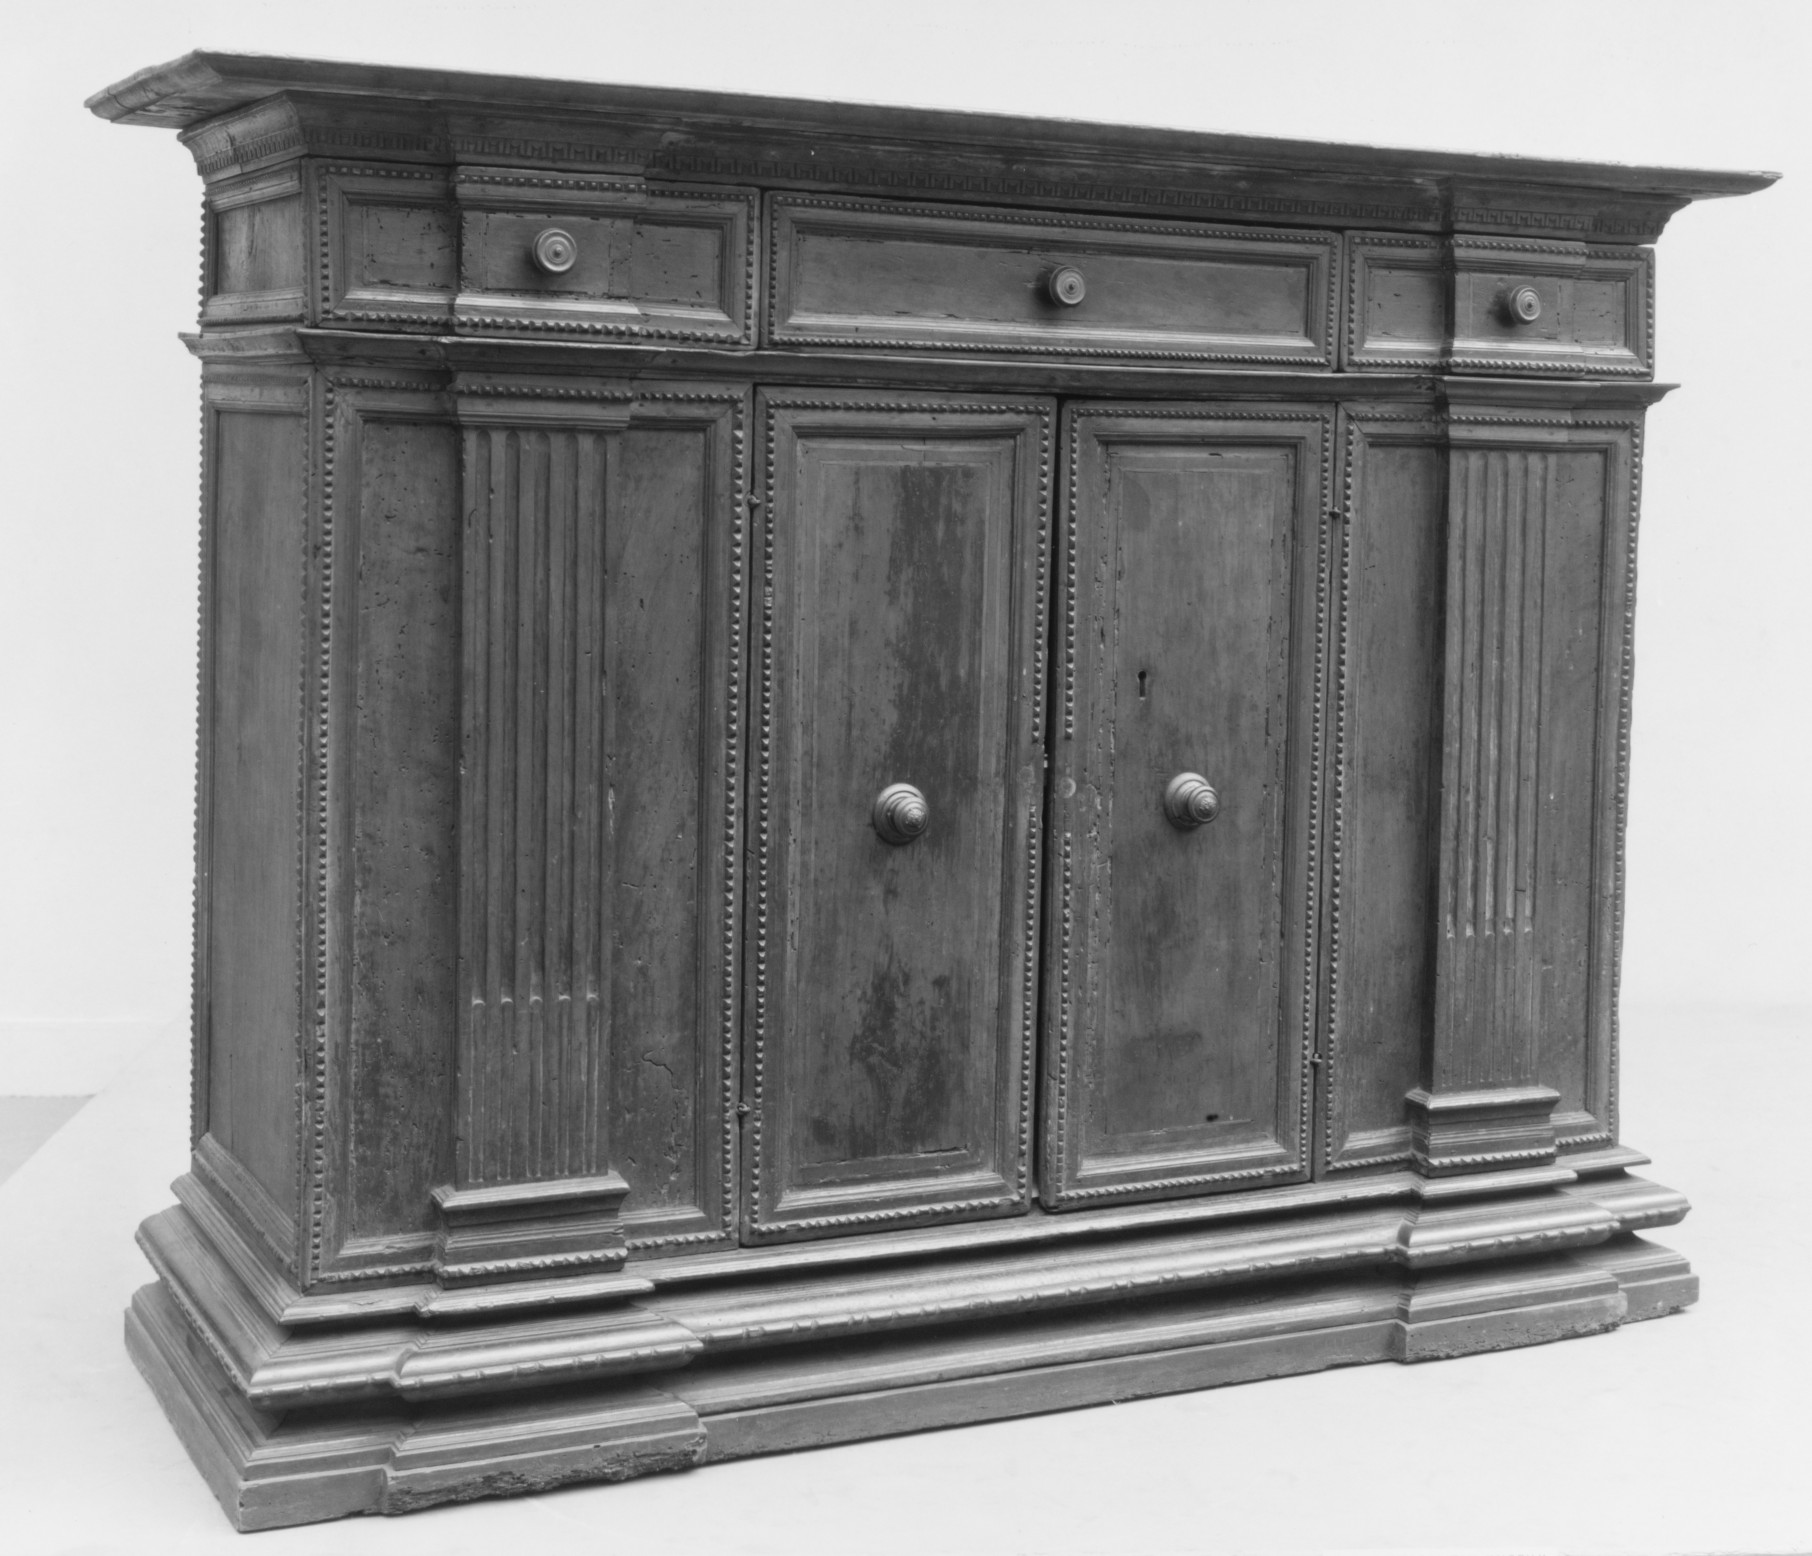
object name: cabinet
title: Cabinet (credenza)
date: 1551-1600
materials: wood